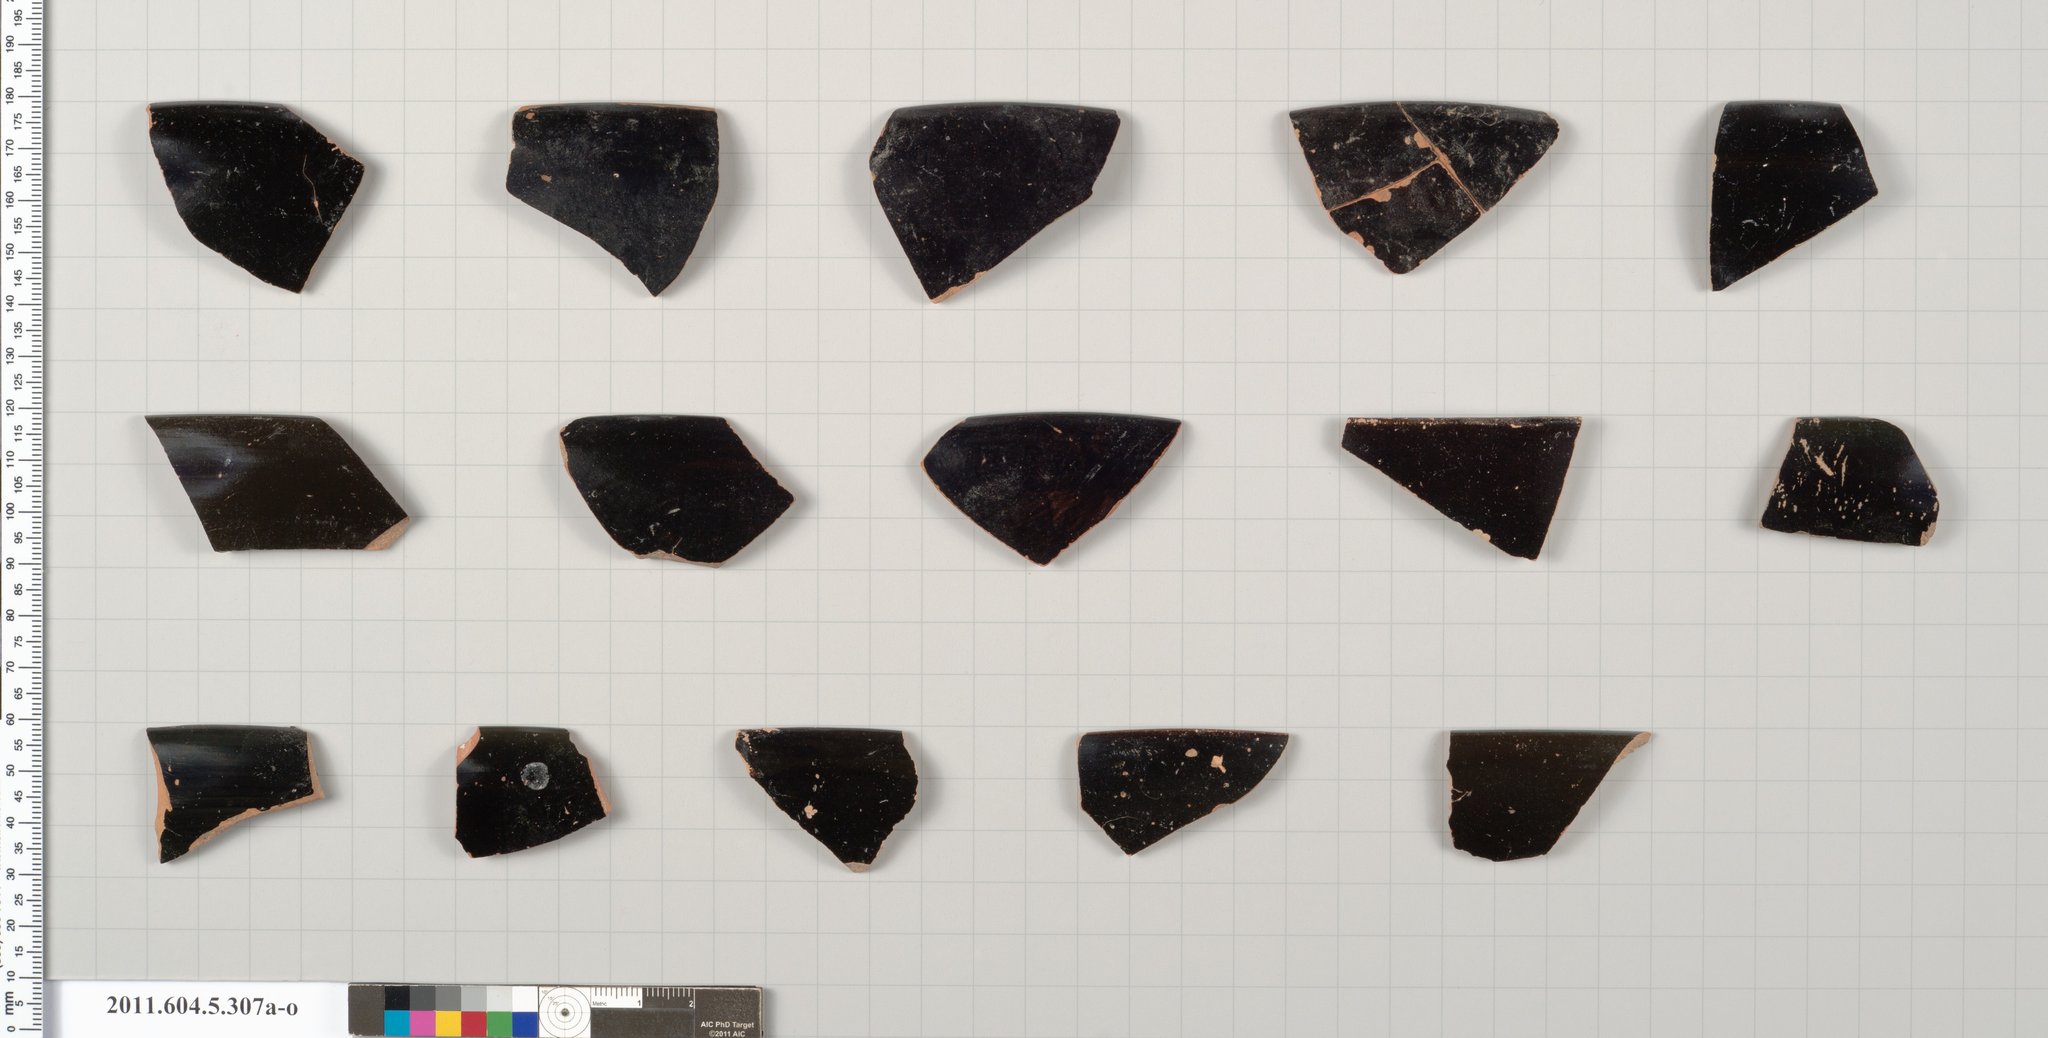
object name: kylix fragment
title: Terracotta rim fragments of kylikes (drinking cups)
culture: greek, attic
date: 600-401 BCE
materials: terracotta